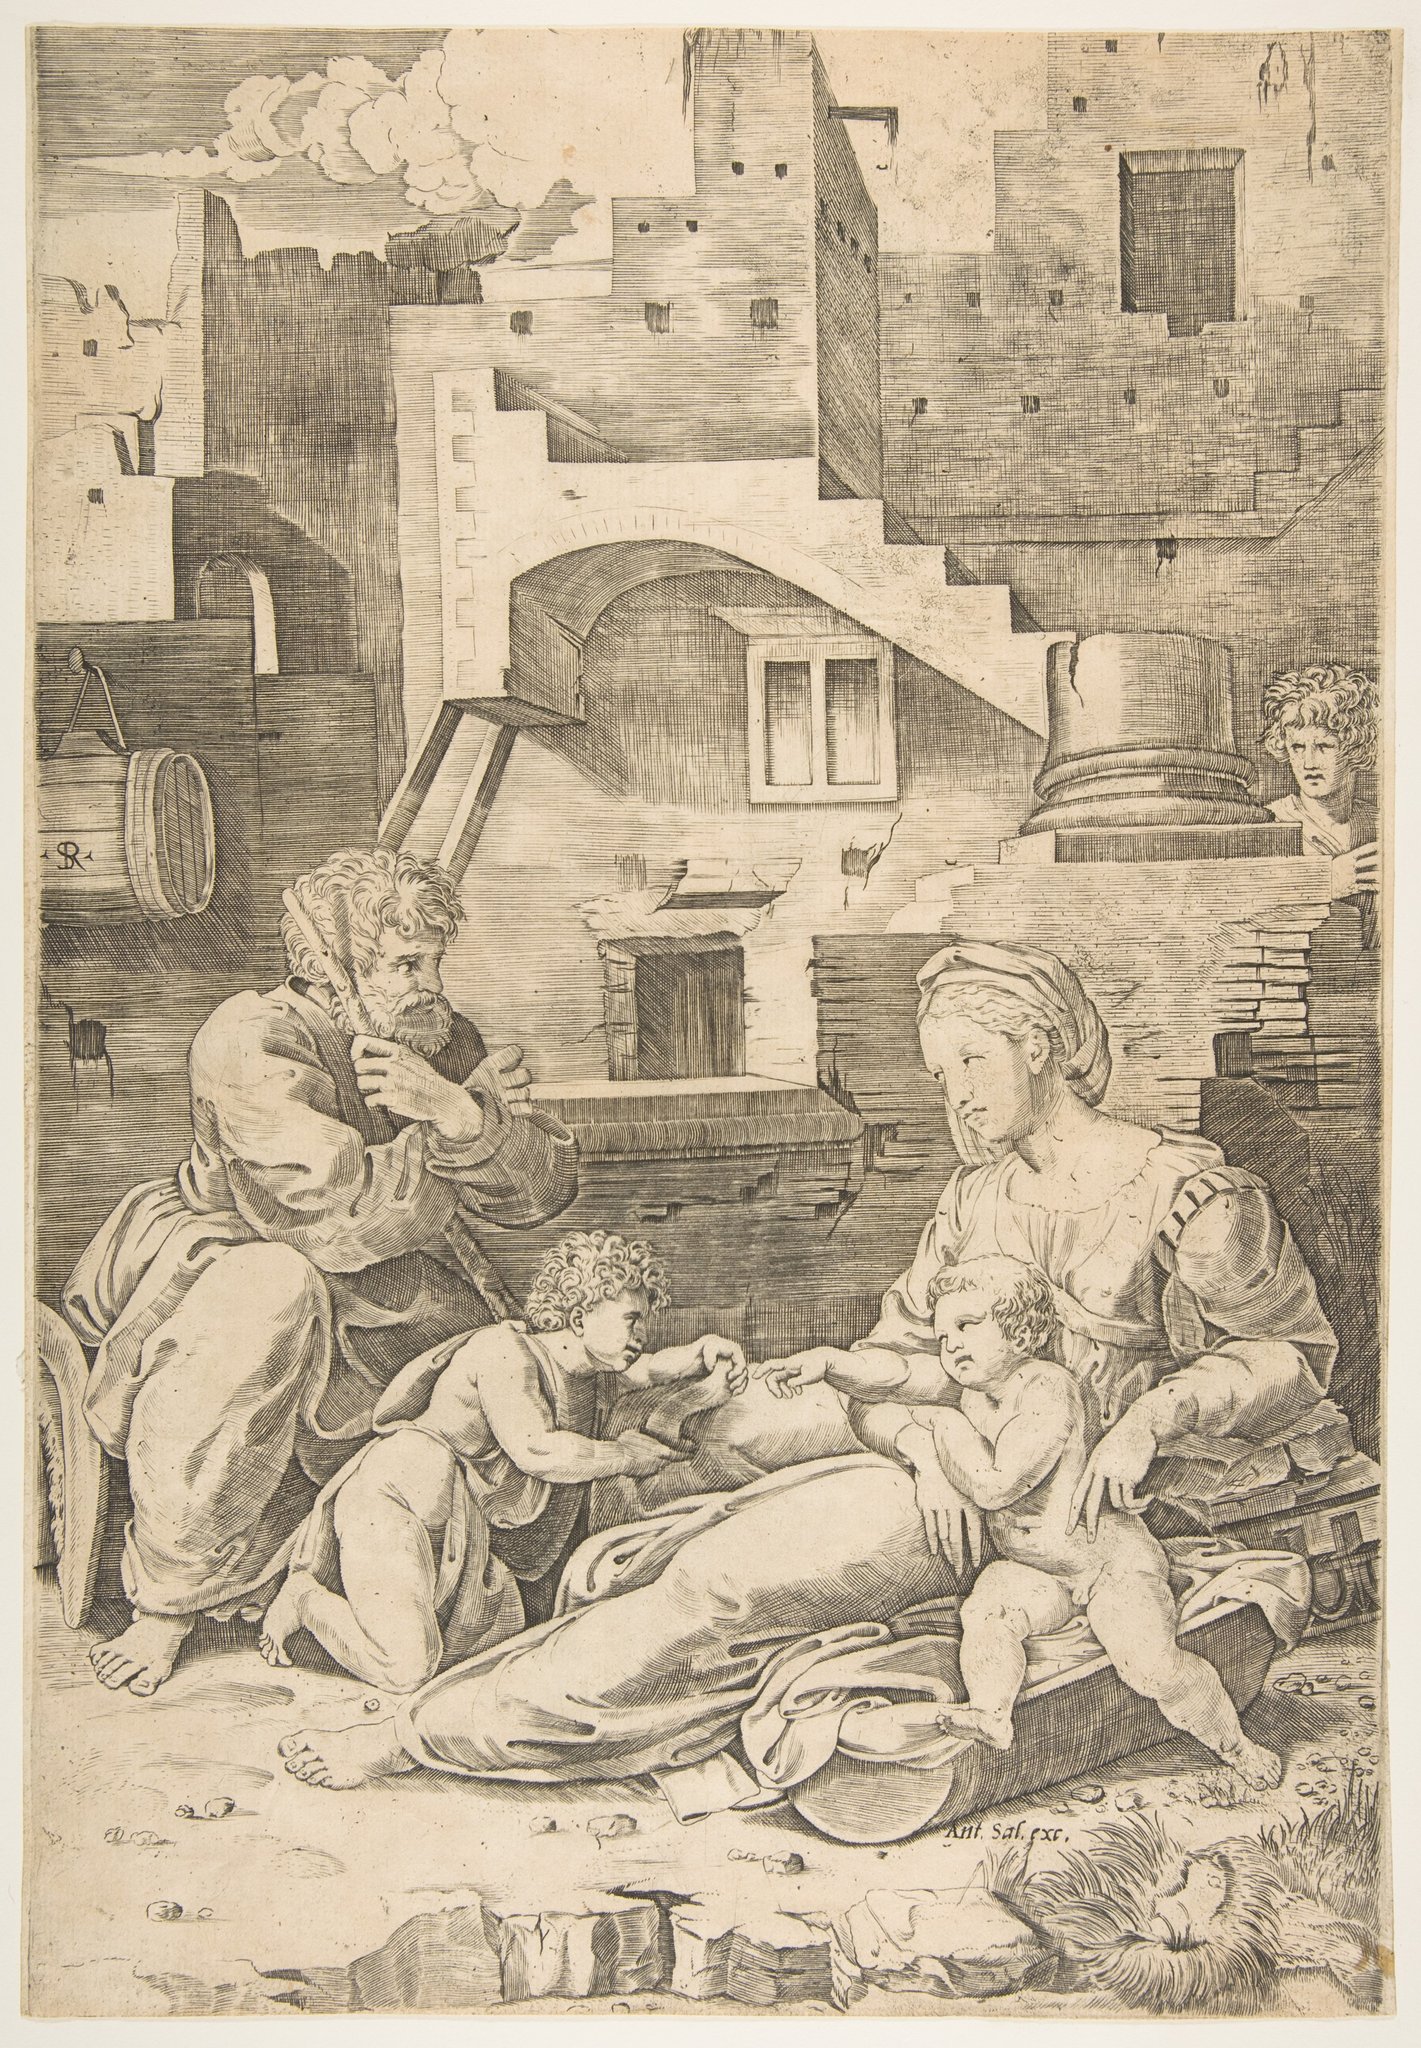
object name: print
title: Virgin of the Long Thigh; the Virgin reclining on the ground her left leg outstretched supporting the infant Christ who reaches across to the infant John the Baptist, Joseph seated at left, buildings in the background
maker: marco dente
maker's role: artist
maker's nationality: italian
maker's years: 1515-1527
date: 1518-1527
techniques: engraving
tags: christ,saint john the baptist,saint joseph,virgin mary